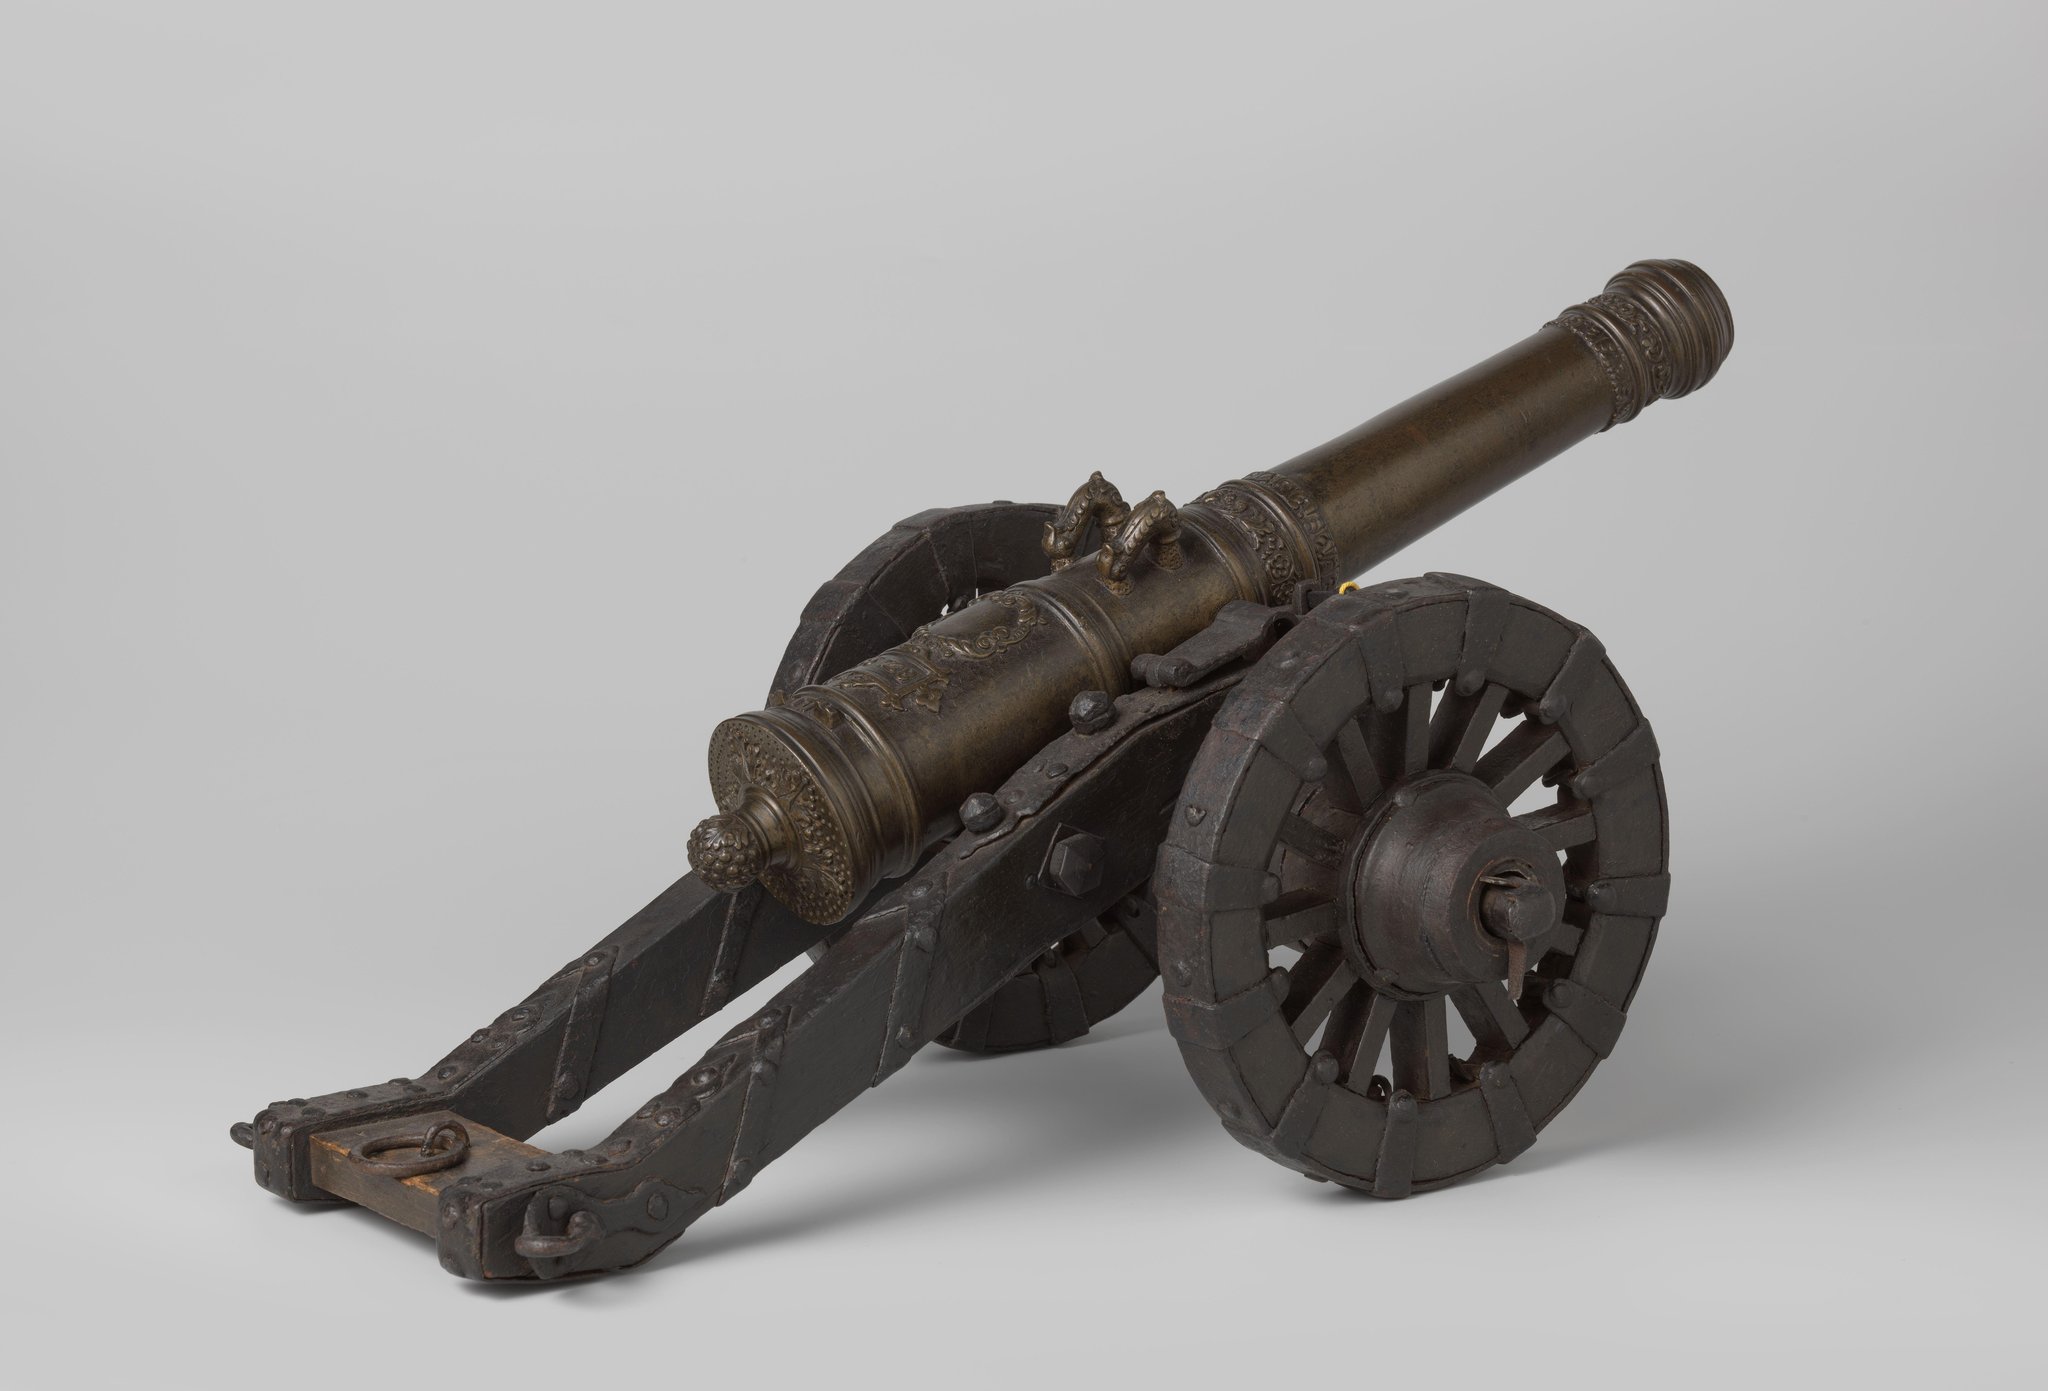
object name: gunmodel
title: Model scheepskanon op affuit, 1628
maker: Anonymous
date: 1628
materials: bronze, wood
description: Model van bronzen scheepskanon op eikenhouten affuit.